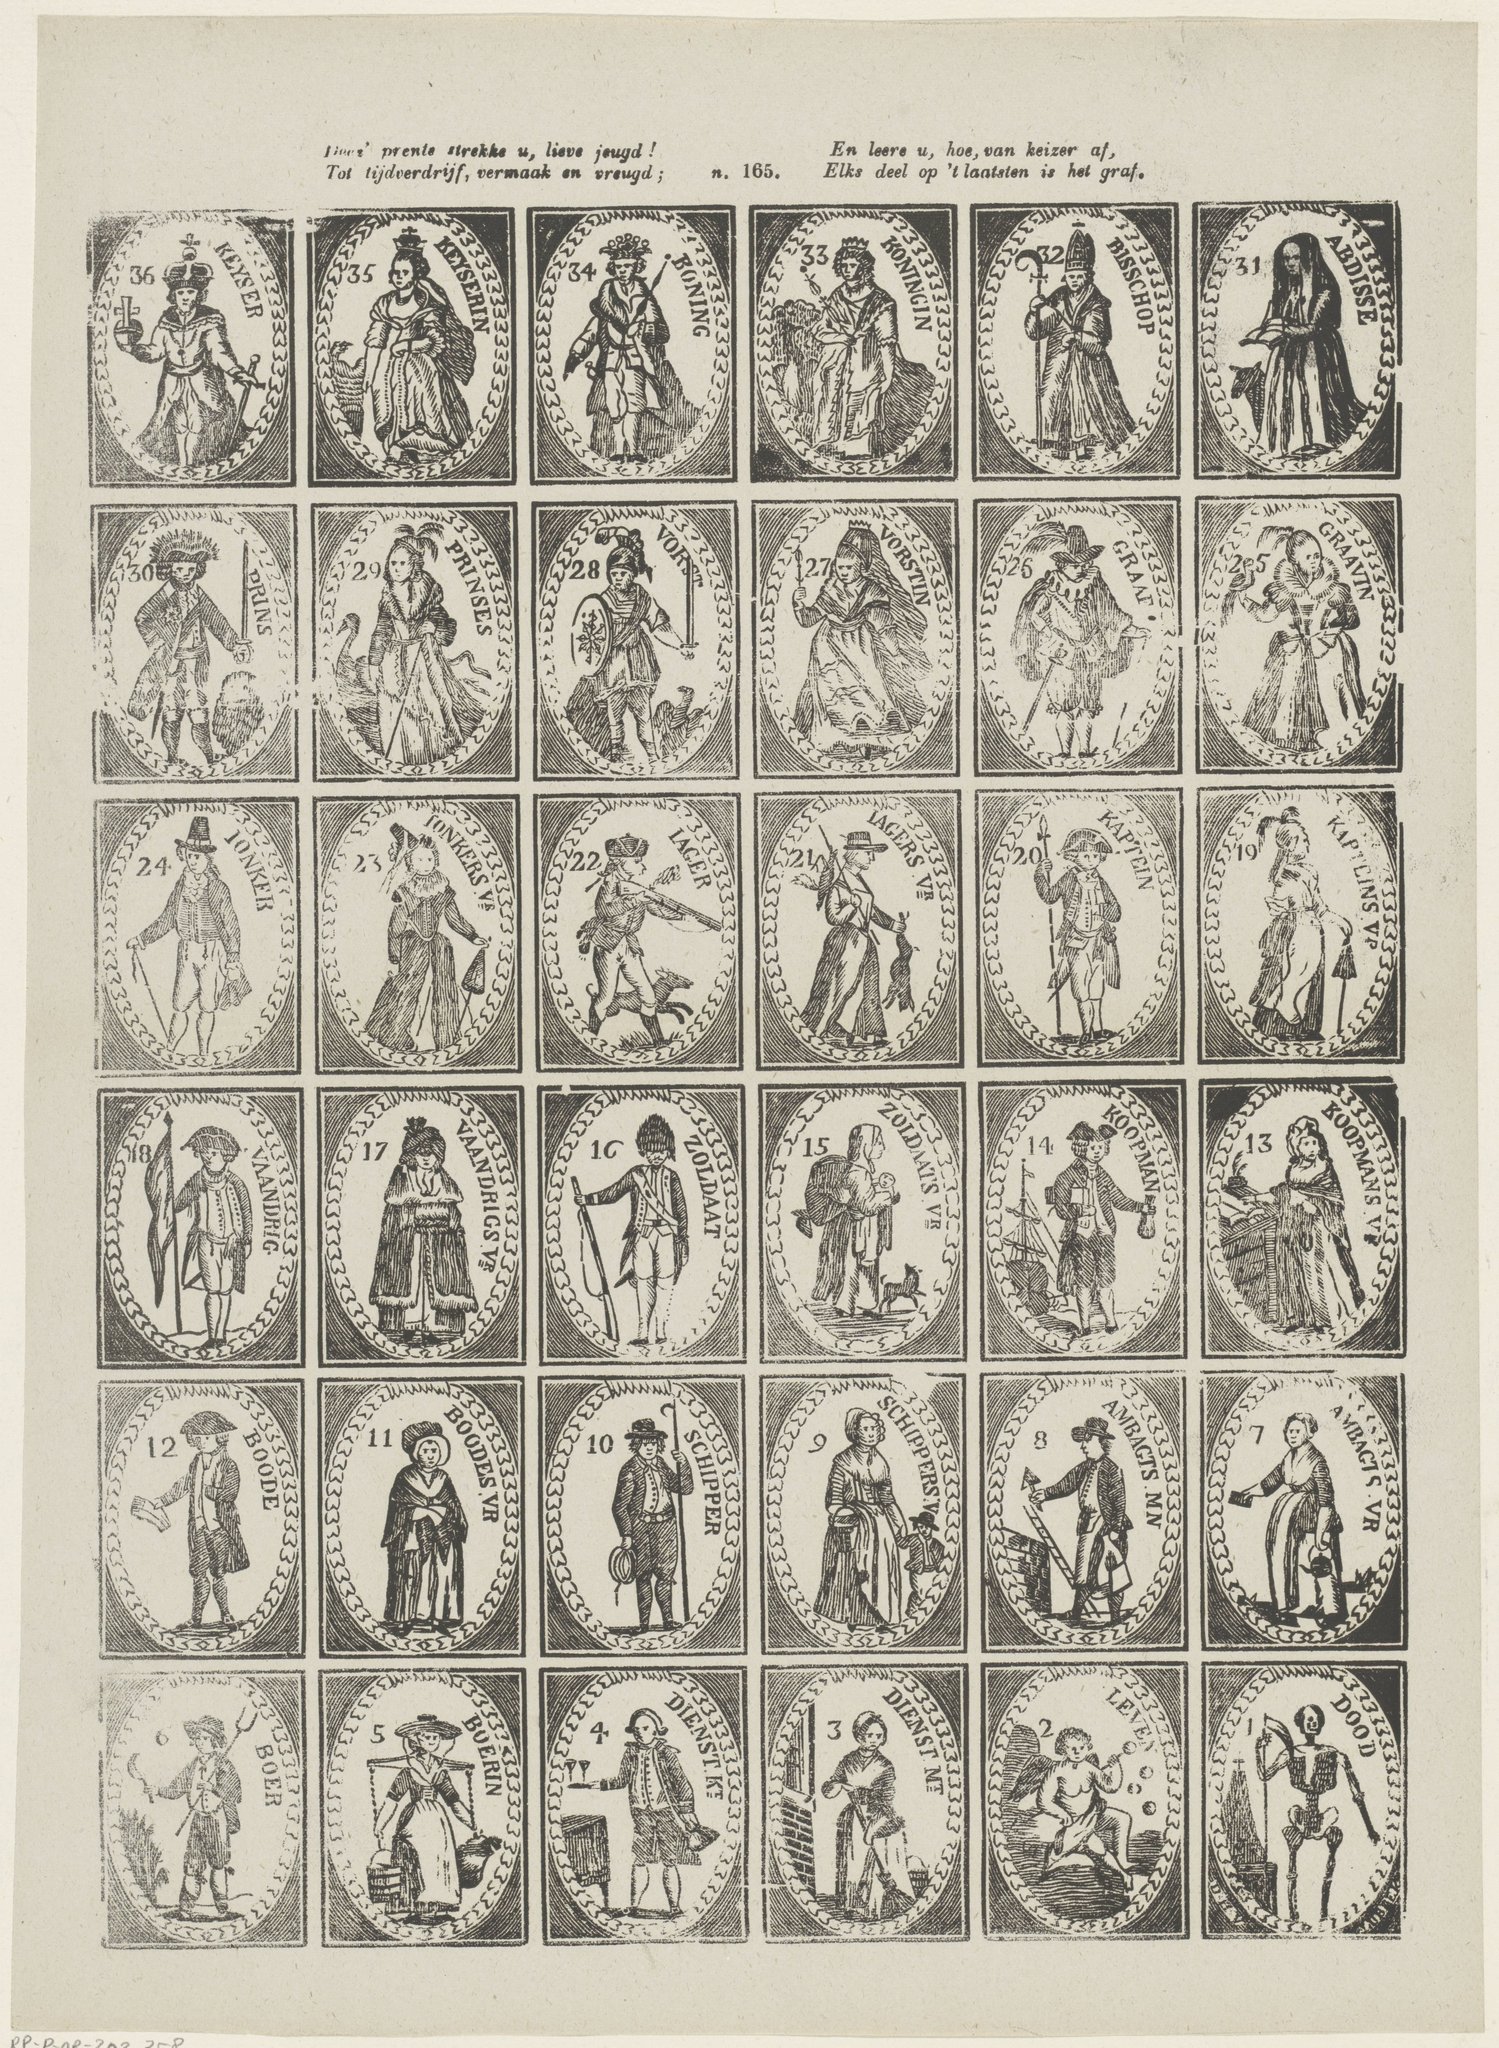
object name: popular print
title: Deez' prente strekke u, lieve jeugd! / Tot tijdverdrijf, vermaak en vreugd; / En leere u, hoe, van keizer af, / Elke deel op 't laatsten is het graf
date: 1833-1900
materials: paper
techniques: letterpress printing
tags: symbols and personifications of death, social position, playing-cards, nobility and patriciate; chivalry, knighthood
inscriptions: collector's mark: Lugt 2760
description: Blad met 36 speelkaarten (floskaartjes) met voorstellingen van verschillende figuren. De afbeeldingen vormen achttien paren, aflopend genummerd van bovenaan links nummer 36 tot onderaan rechts nummer 1. Op de twee laagste nummers na tonen ze zeventien koppels, man en vrouw, met de man net één nummer hoger dan de vrouw, waarbij elk paar een beroep of een maatschappelijke positie voorstelt. Genummerd midden boven: n. 165.